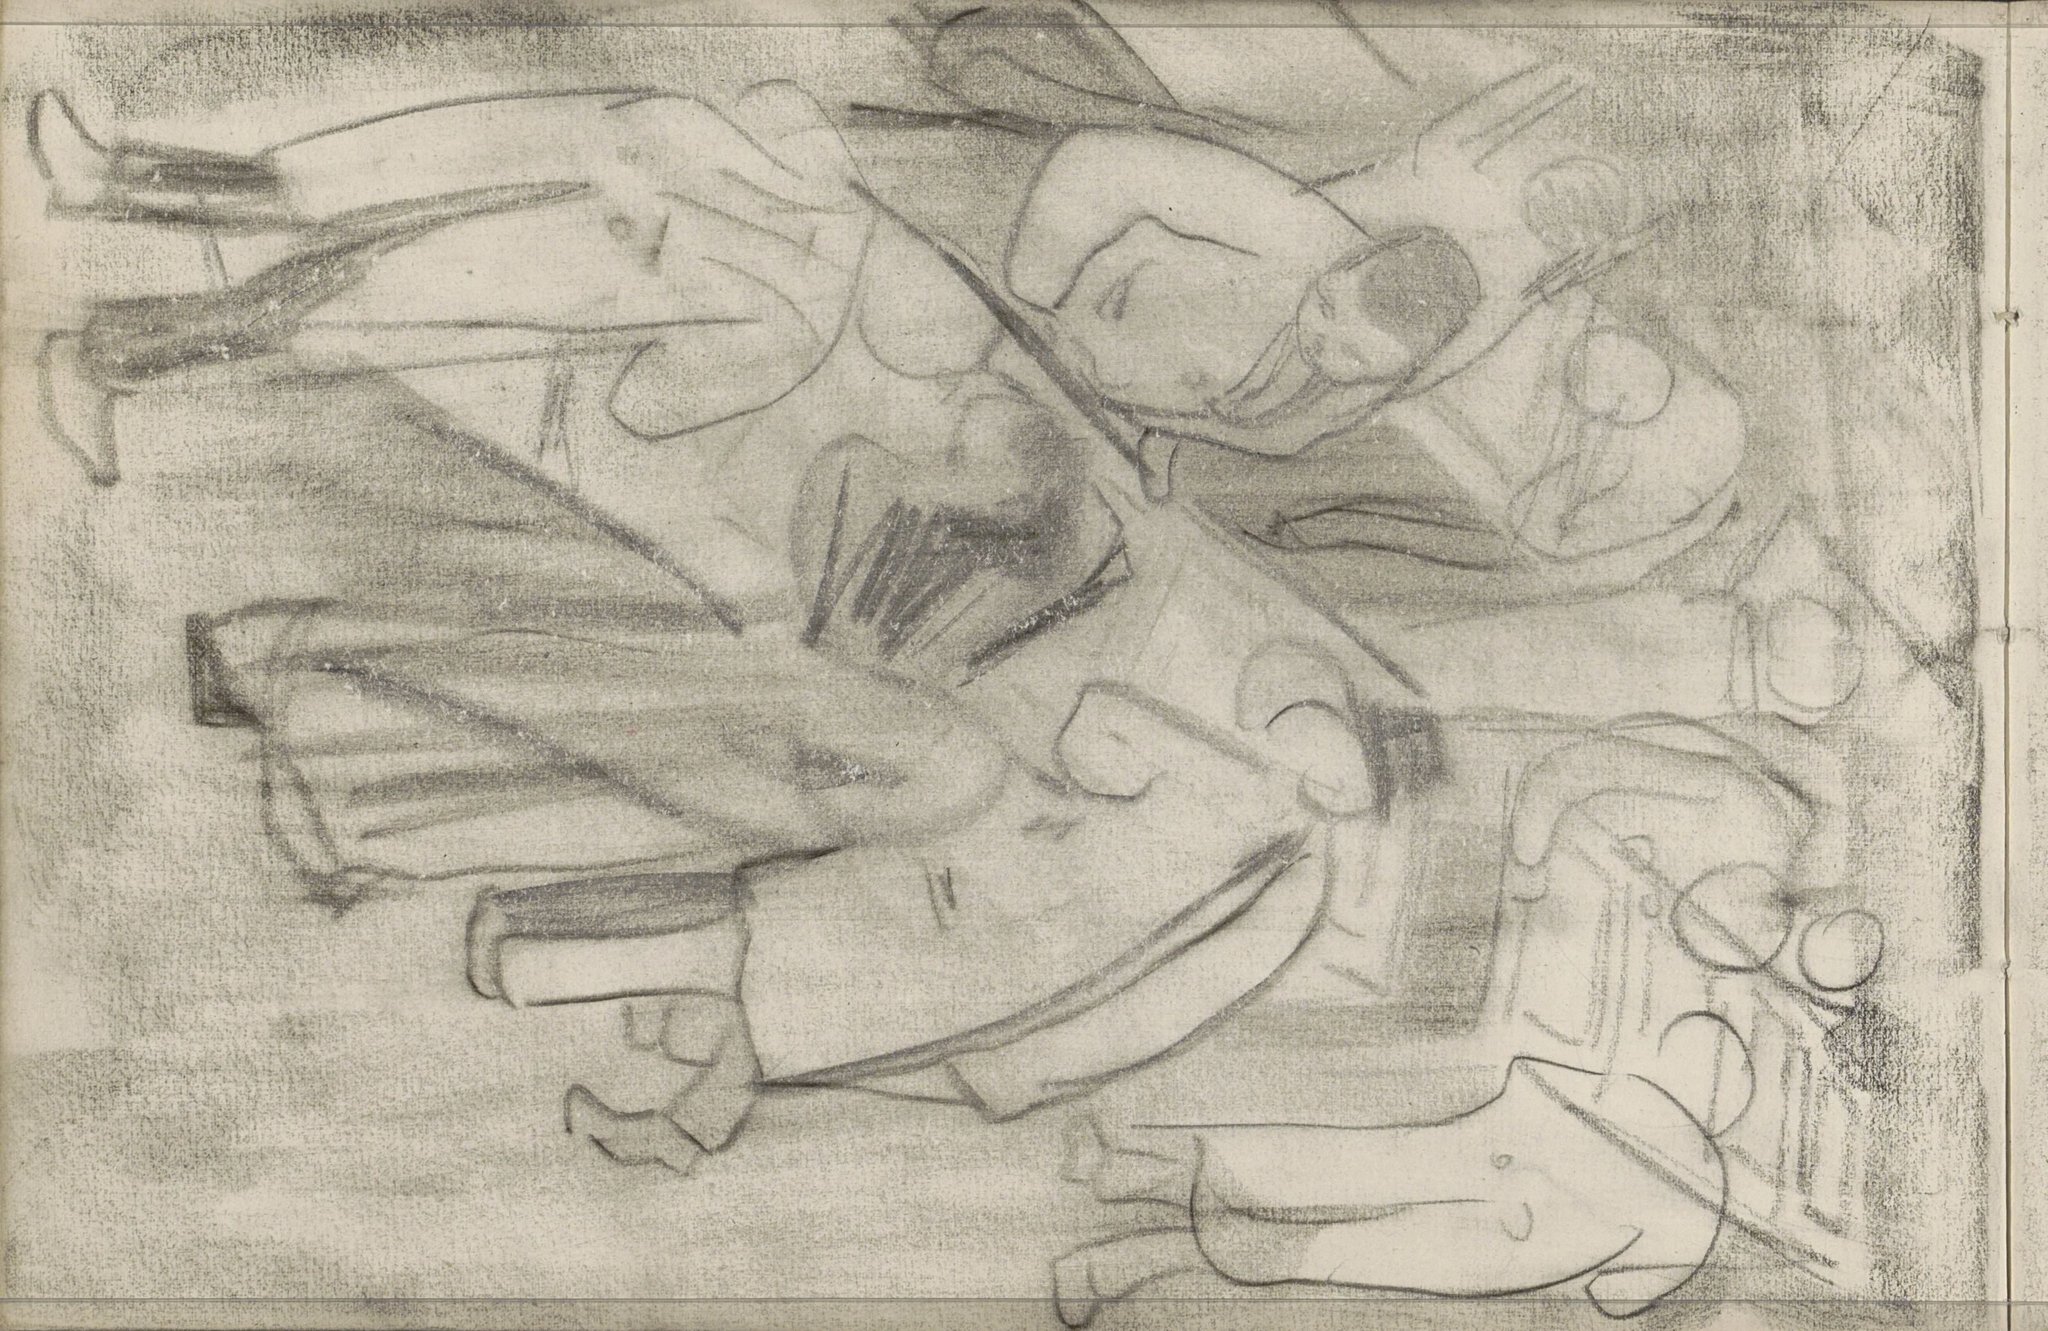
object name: sketchbook leaf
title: Figuren die op tafels uitgestalde objecten bestuderen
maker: carel adolph lion cachet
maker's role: draughtsman, print maker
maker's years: 1864-1945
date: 1895-1900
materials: chalk, paper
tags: exhibition ~ art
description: Mogelijk een tentoonstelling. Blad 12 verso uit een schetsboek met 19 bladen.